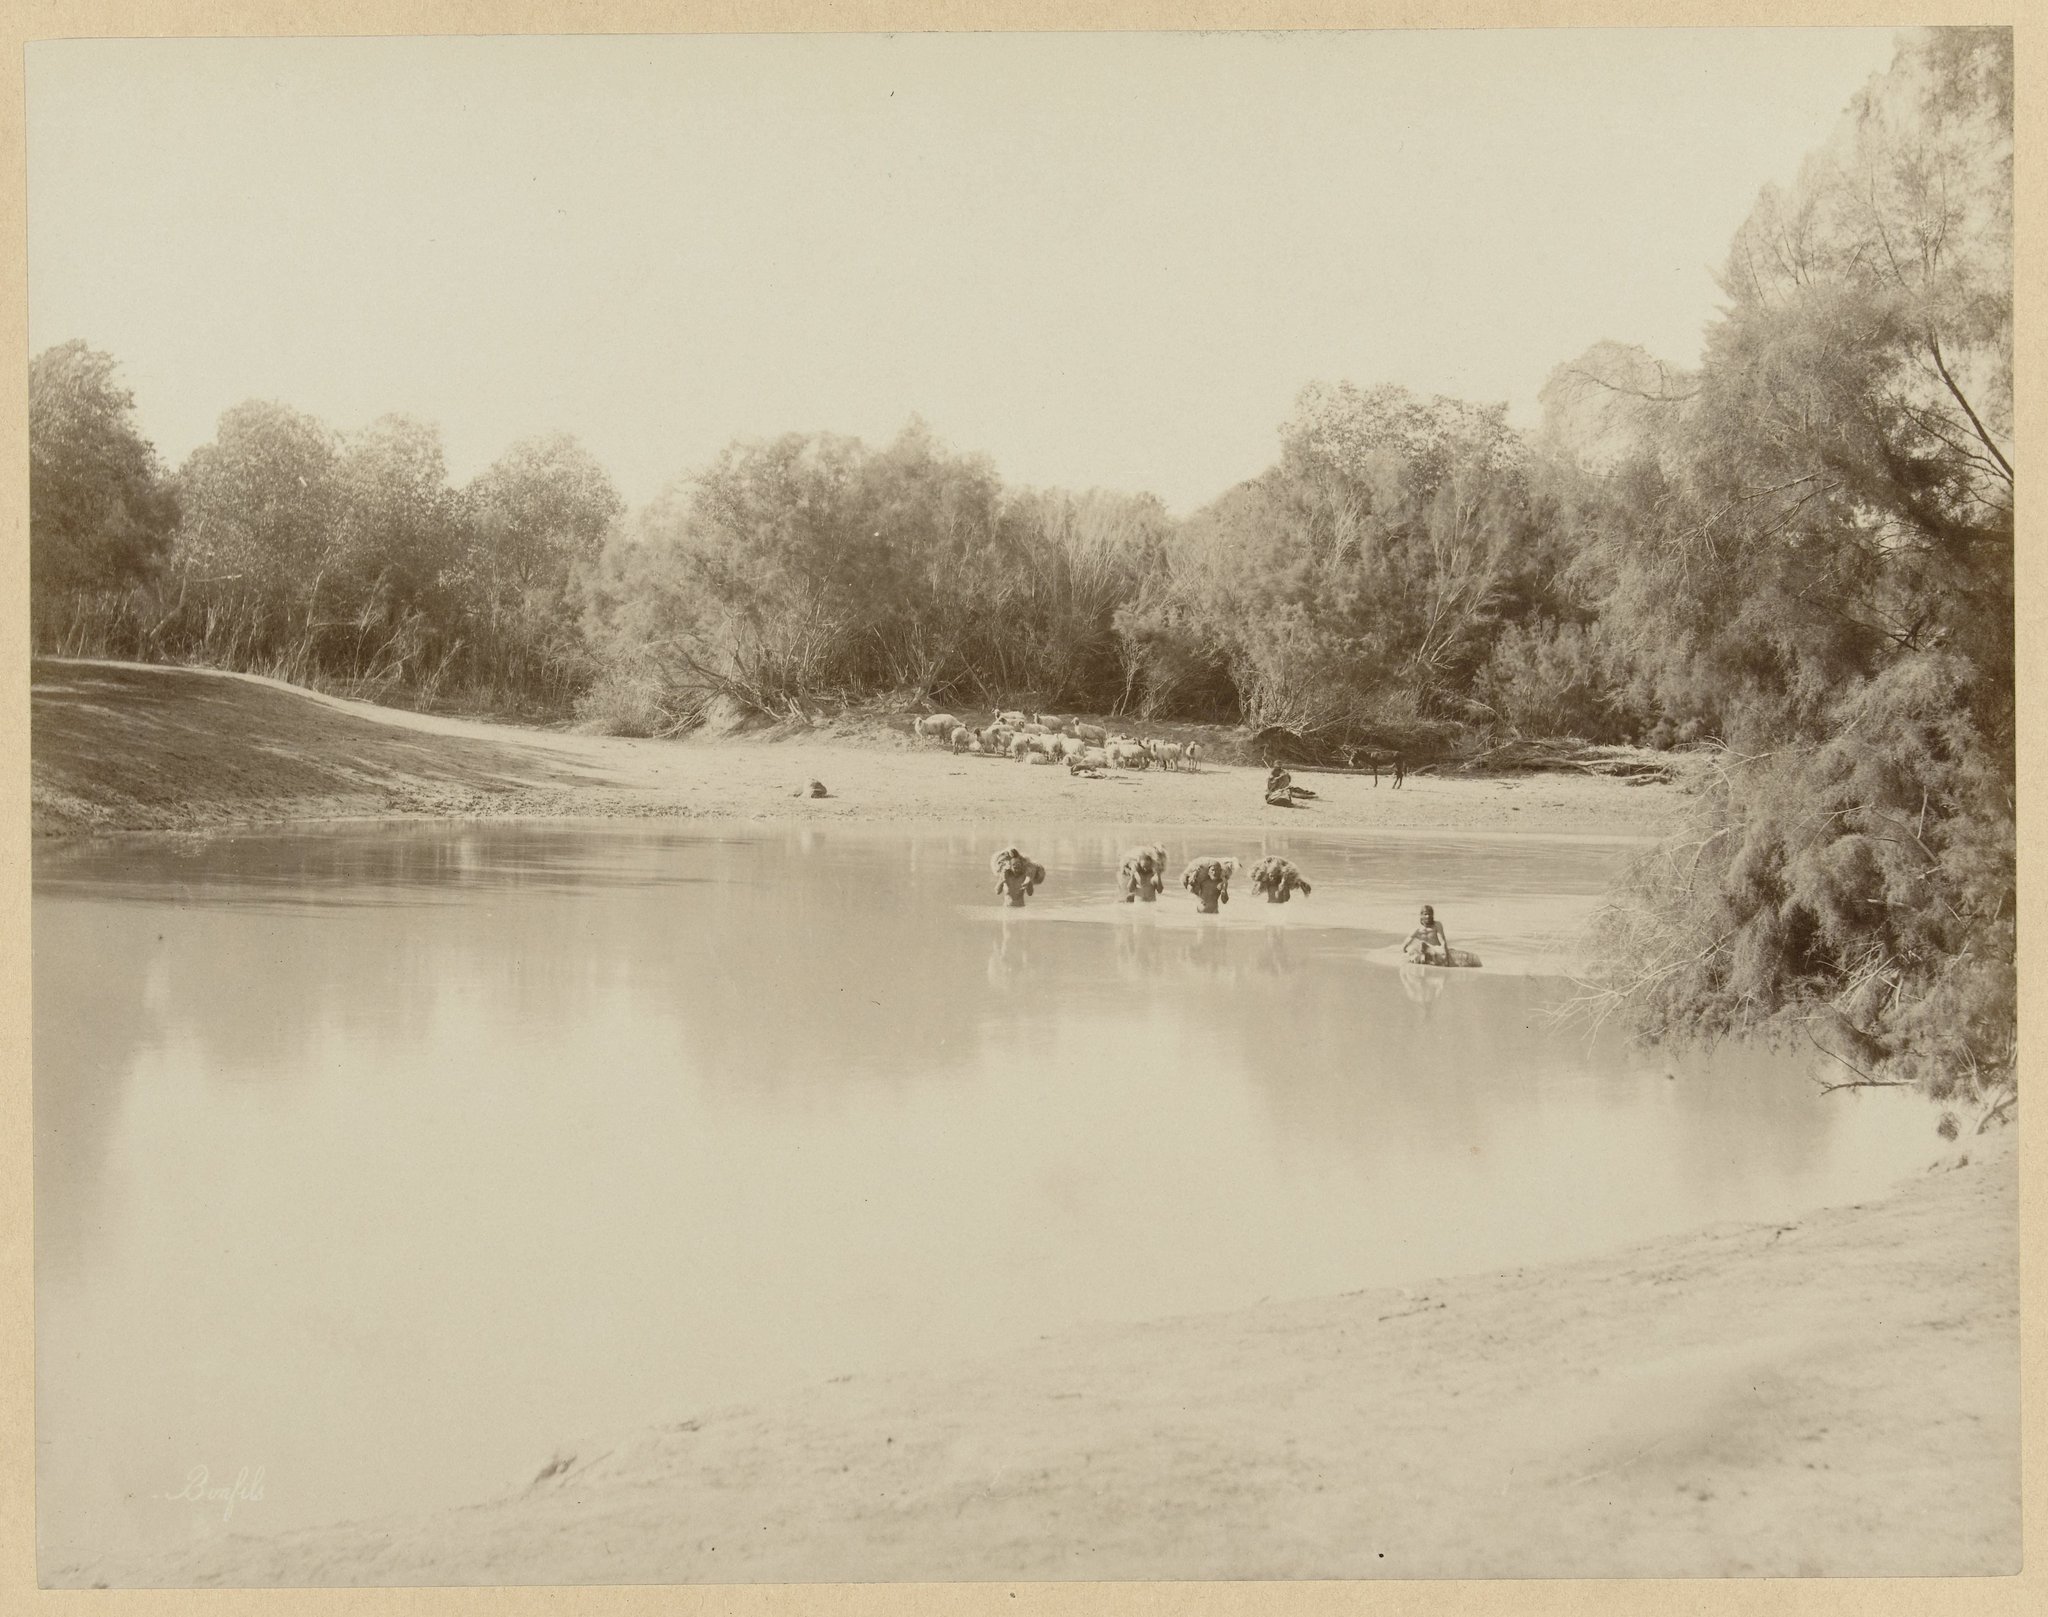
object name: photograph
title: S 62. Herders hunne schapen over de Jordaan dragend. Syrië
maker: félix bonfils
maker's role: fotograaf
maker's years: 1831-1885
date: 1867-1877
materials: cardboard, paper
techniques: albumen print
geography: ottoman empire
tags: shepherd with sheep or lamb on his shoulders, river, carrying something on the head or on the shoulders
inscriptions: check stamp: ‘Bristol/ L.M.’, title: ‘S 62. Herders hunne schapen over de Jordaan dragend. Syrië.’, stamp: ‘Gemeentelijke bibliotheek/ Rotterdam’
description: Onderdeel van een groep door fotograaf Richard Polak op reis verzamelde foto’s. Deze foto is samen met andere op zijn reizen verzamelde foto's tentoongesteld bij de Rotterdamsche Kunstkring (1895), Arti en Amicitiae te Amsterdam (1897-1898?) en Societeit 't Collegie te Kampen (datum vooralsnog onbekend).